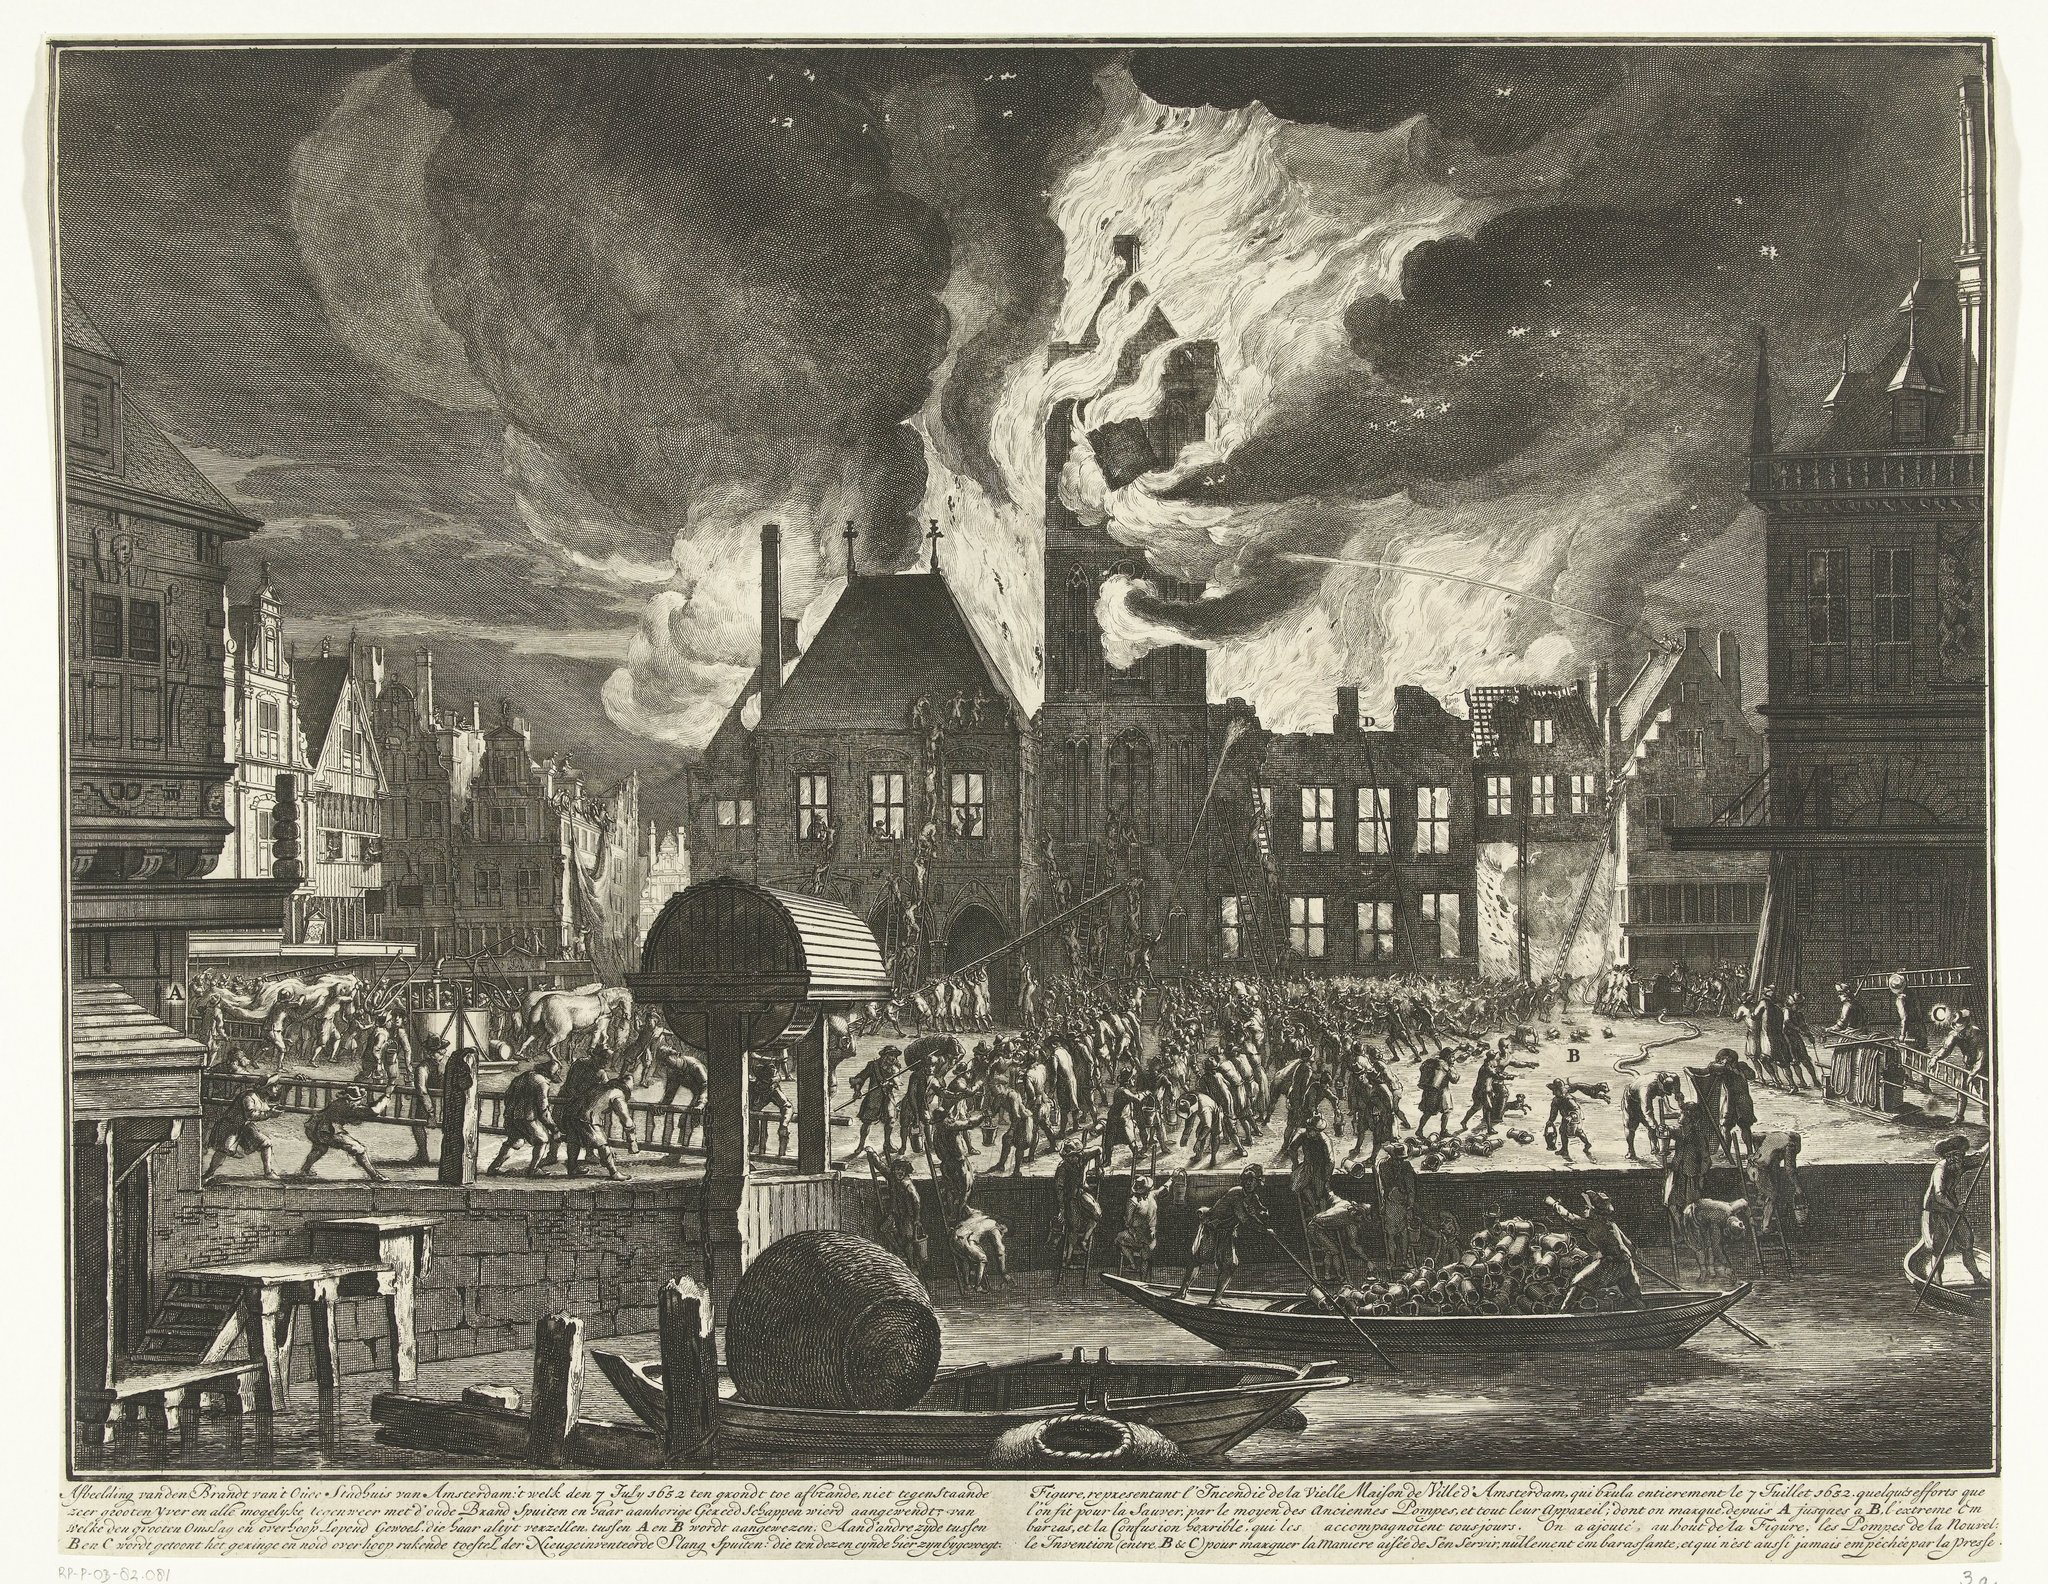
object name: print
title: De brand in het Oude Stadhuis van Amsterdam, 1652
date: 1690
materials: paper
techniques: engraving, etching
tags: print maker, draughtsman, jan van der heyden, on fire, ablaze, townhall, fire-fighting, fire-extinguishing equipment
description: Huidige staat van prent ook gebruikt in: Heyden, Jan van der. Beschryving der nieuwlyks uitgevonden en geoctrojeerde slang-brand-spuiten en haare wyze van brand-blussen, tegenwoordig binnen Amsterdam in gebruik zijnde (…). 1e druk. Amsterdam: Jan Rieuwertsz. (II), 1690. Derde bekende staat van prent ook gebruikt in: Heyden, Jan van der. Beschryving der nieuwlyks uitgevonden en geoctrojeerde slang-brand-spuiten en haare wyze van brand-blussen, tegenwoordig binnen Amsterdam in gebruik zijnde (…). 2e druk. Amsterdam: erfgenamen Jan van der Heyden, 1735. Voor eerste bekende staat zie RP-P-AO-28-44-2 en RP-P-OB-55.389. Voor tweede bekende staat zie RP-P-OB-81.741 en RP-P-OB-82.081. Voor derde bekende staat zie RP-P-AO-28-44-1 en RP-P-OB-81.742.